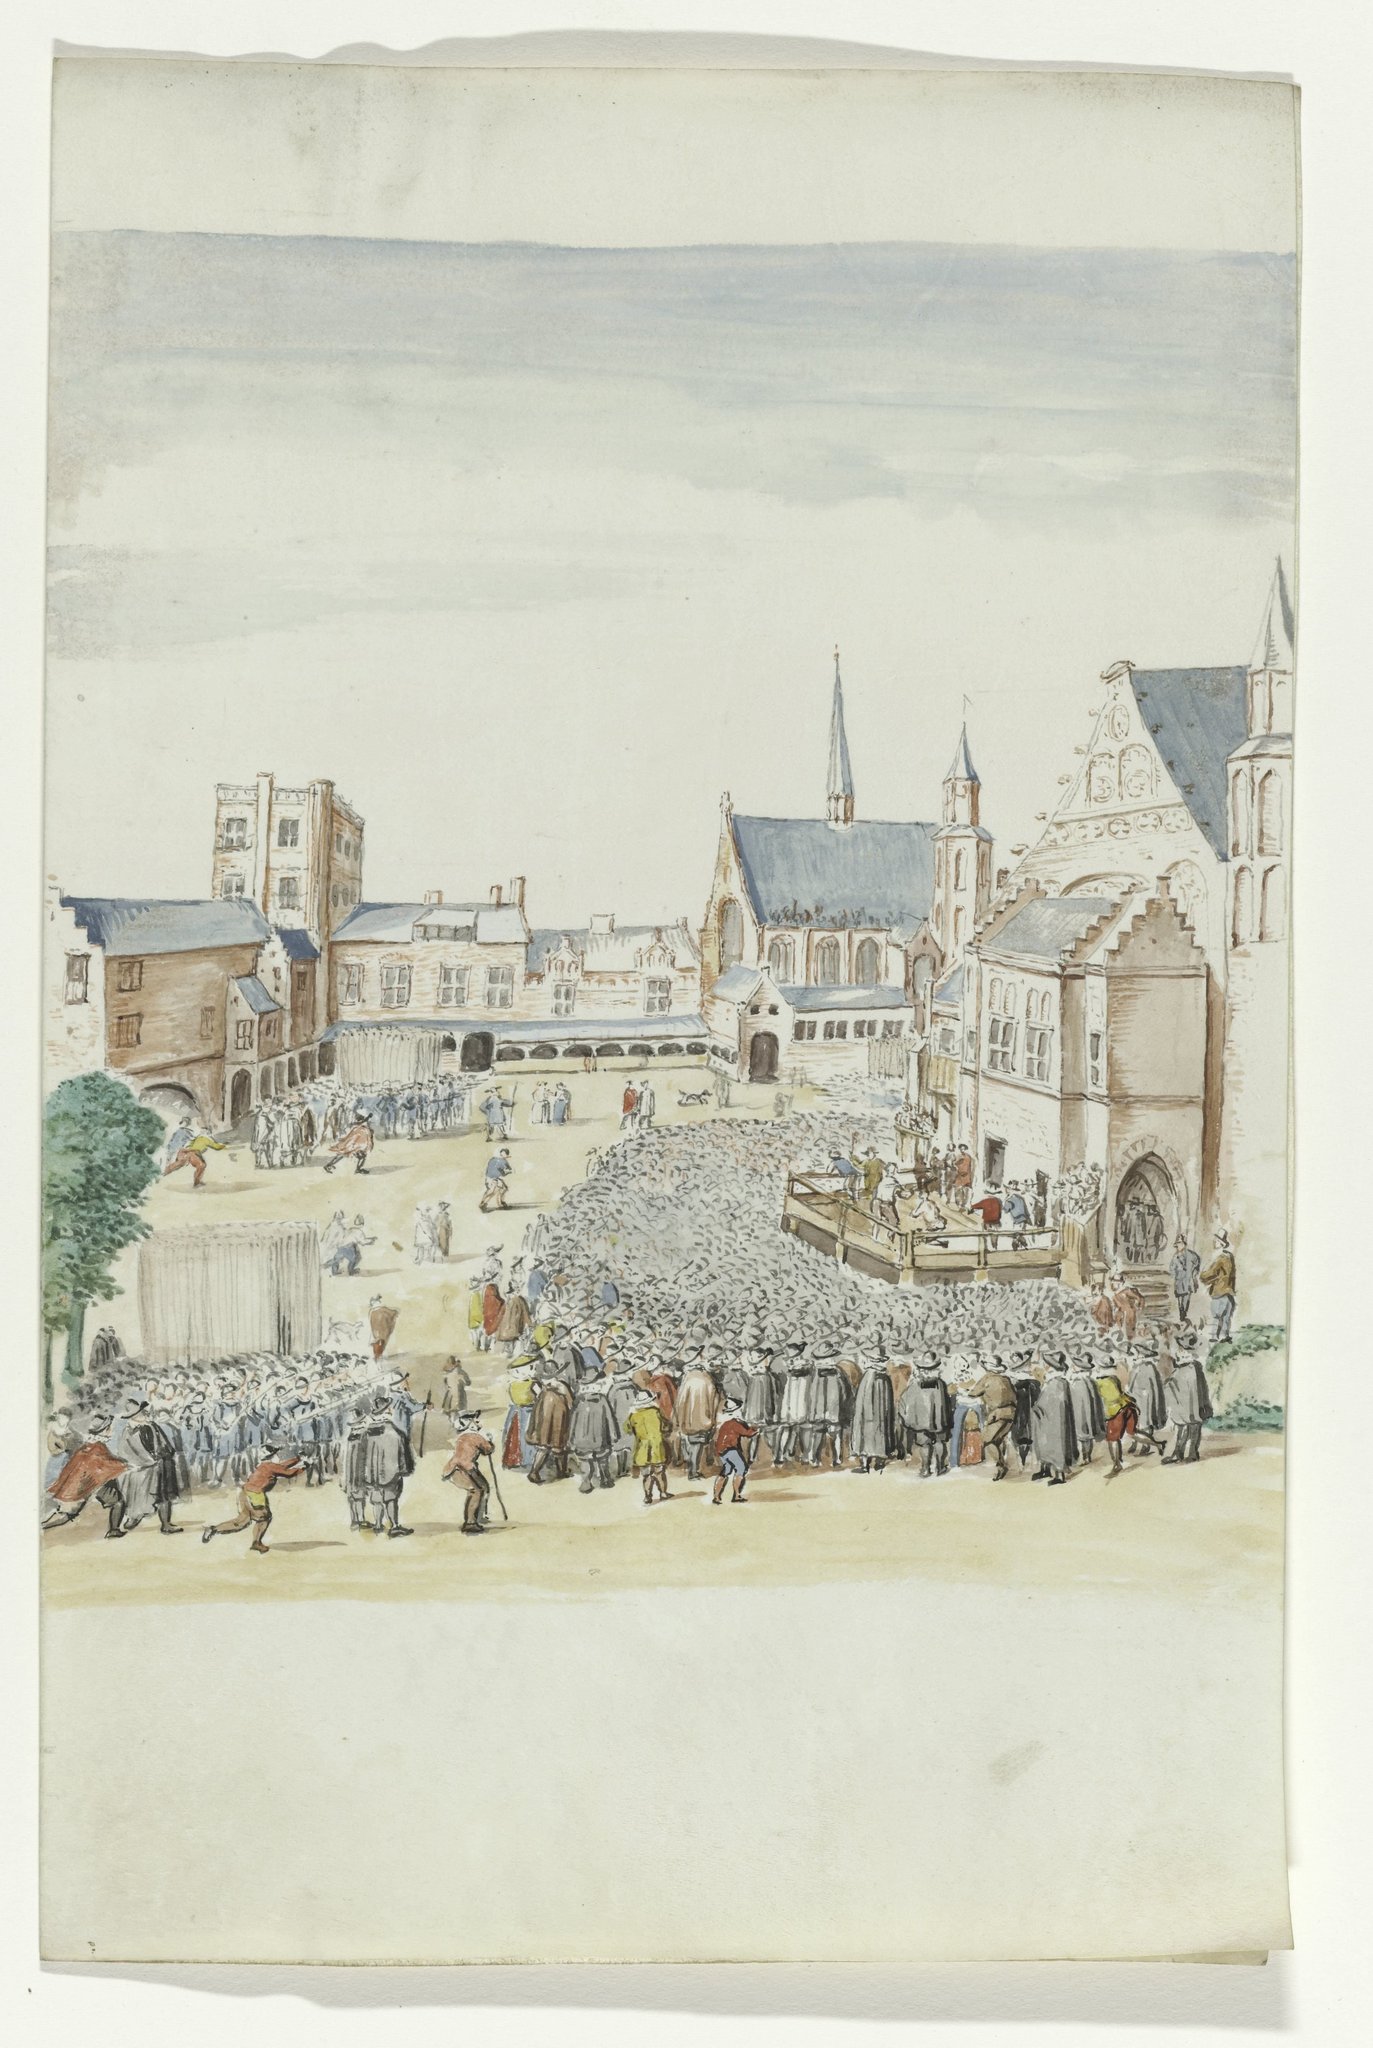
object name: drawing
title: Regtspleging van Oldenbarnevelt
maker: Anonymous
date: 1710-1720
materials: ink, parchment, watercolor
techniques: pen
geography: netherlands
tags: the hague, johan van oldenbarnevelt, violent death by beheading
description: Aquarel waarop menigte zich verzamelt op het Binnenhof voor de terechstelling van Van Oldenbarnevelt. Behorende bij serie aquarellen in boek.